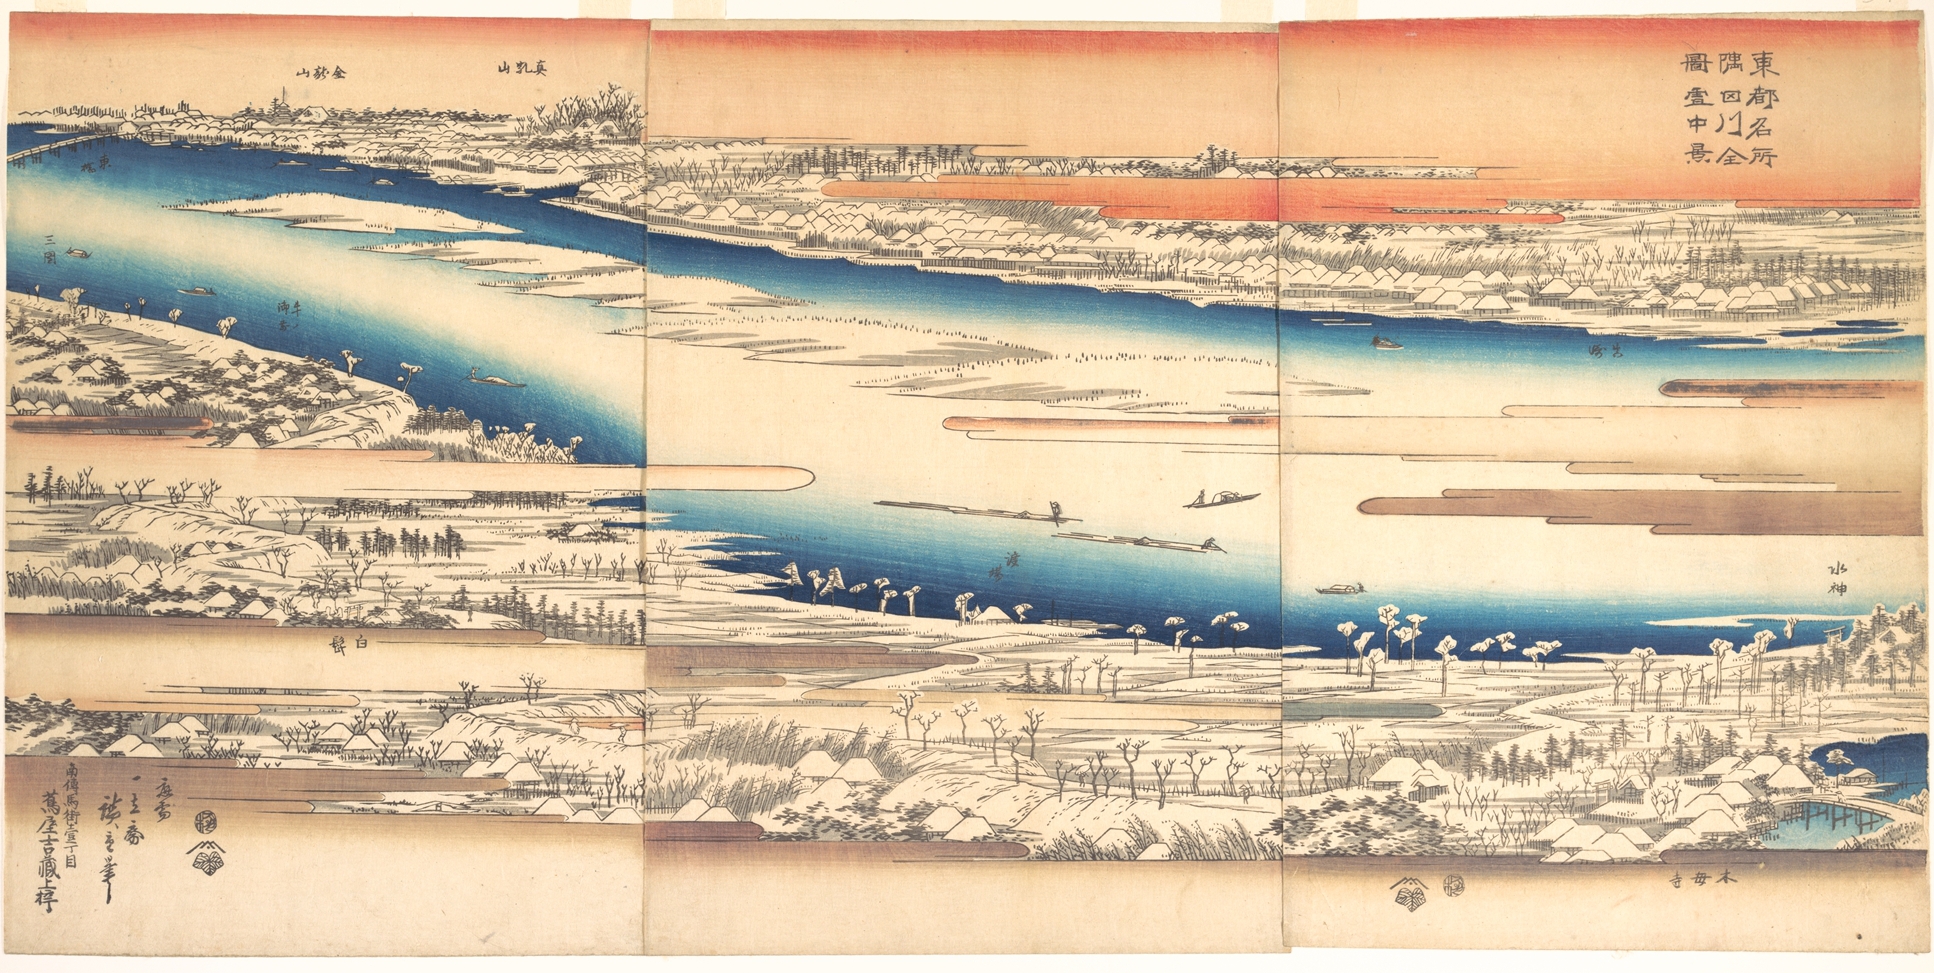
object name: woodblock print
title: Celebrated Places in the Eastern Capital: Panoramic View of the Sumida River in Snow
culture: japanese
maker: utagawa hiroshige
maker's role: artist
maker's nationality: japanese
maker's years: 1797-1858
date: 1840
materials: ink, paper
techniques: woodblock print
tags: rivers,trees,snow